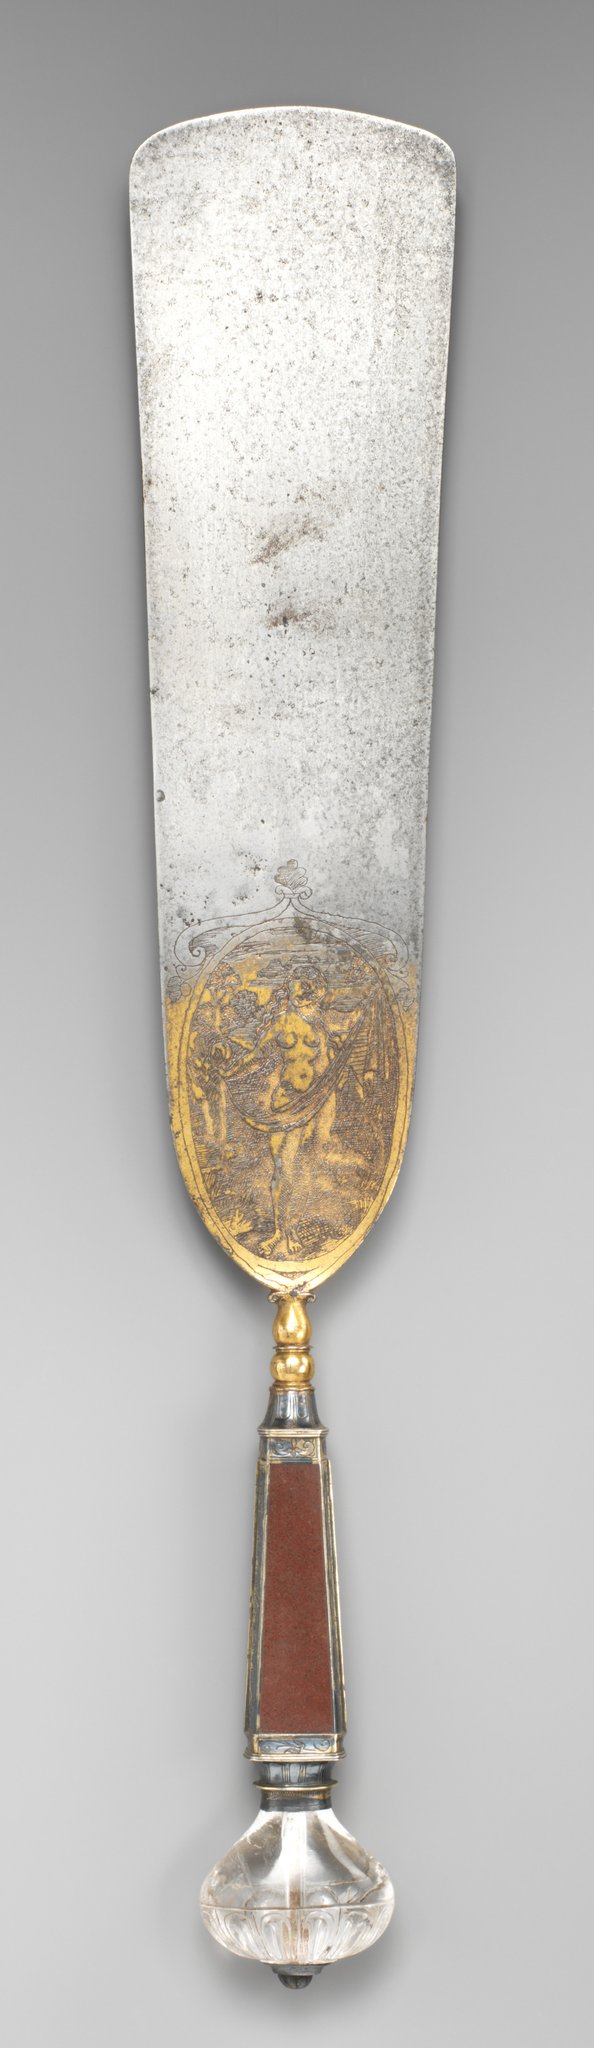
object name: serving knife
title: Serving knife (Présentoir)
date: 1867-1900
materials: crystal, mother of pearl, silver, steel